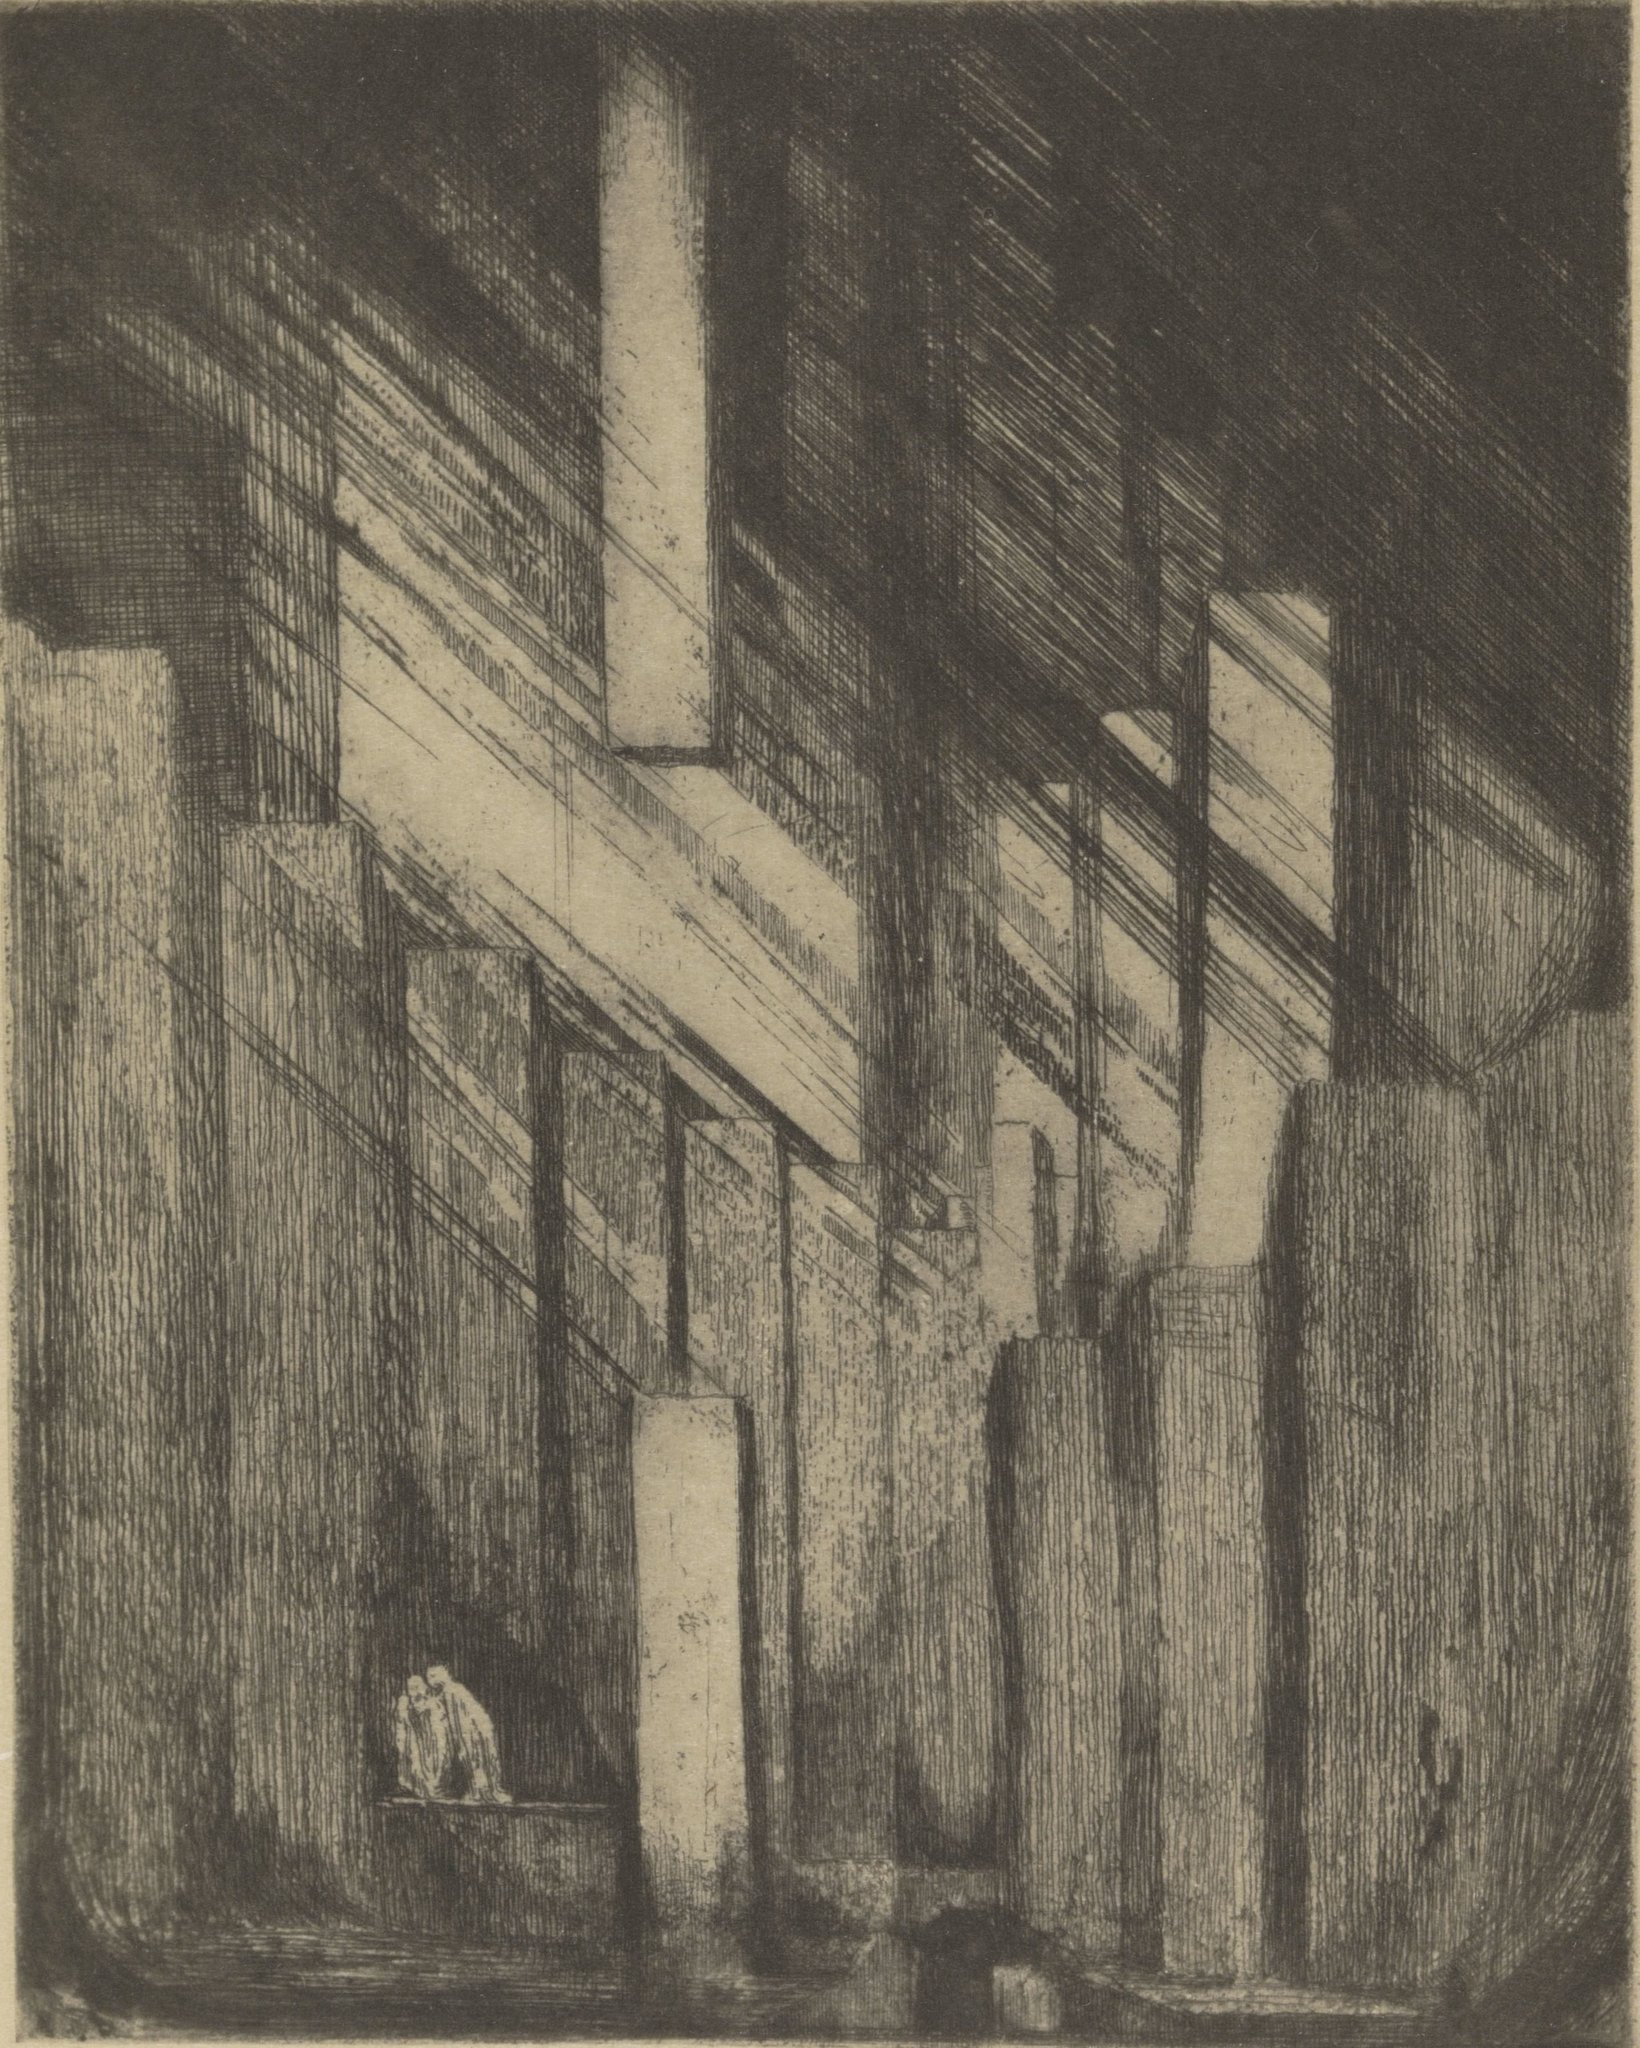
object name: page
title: Reproductie van een ets met een ontwerp voor een theaterdecor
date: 1910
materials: paper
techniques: photoaquatint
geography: england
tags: stage design